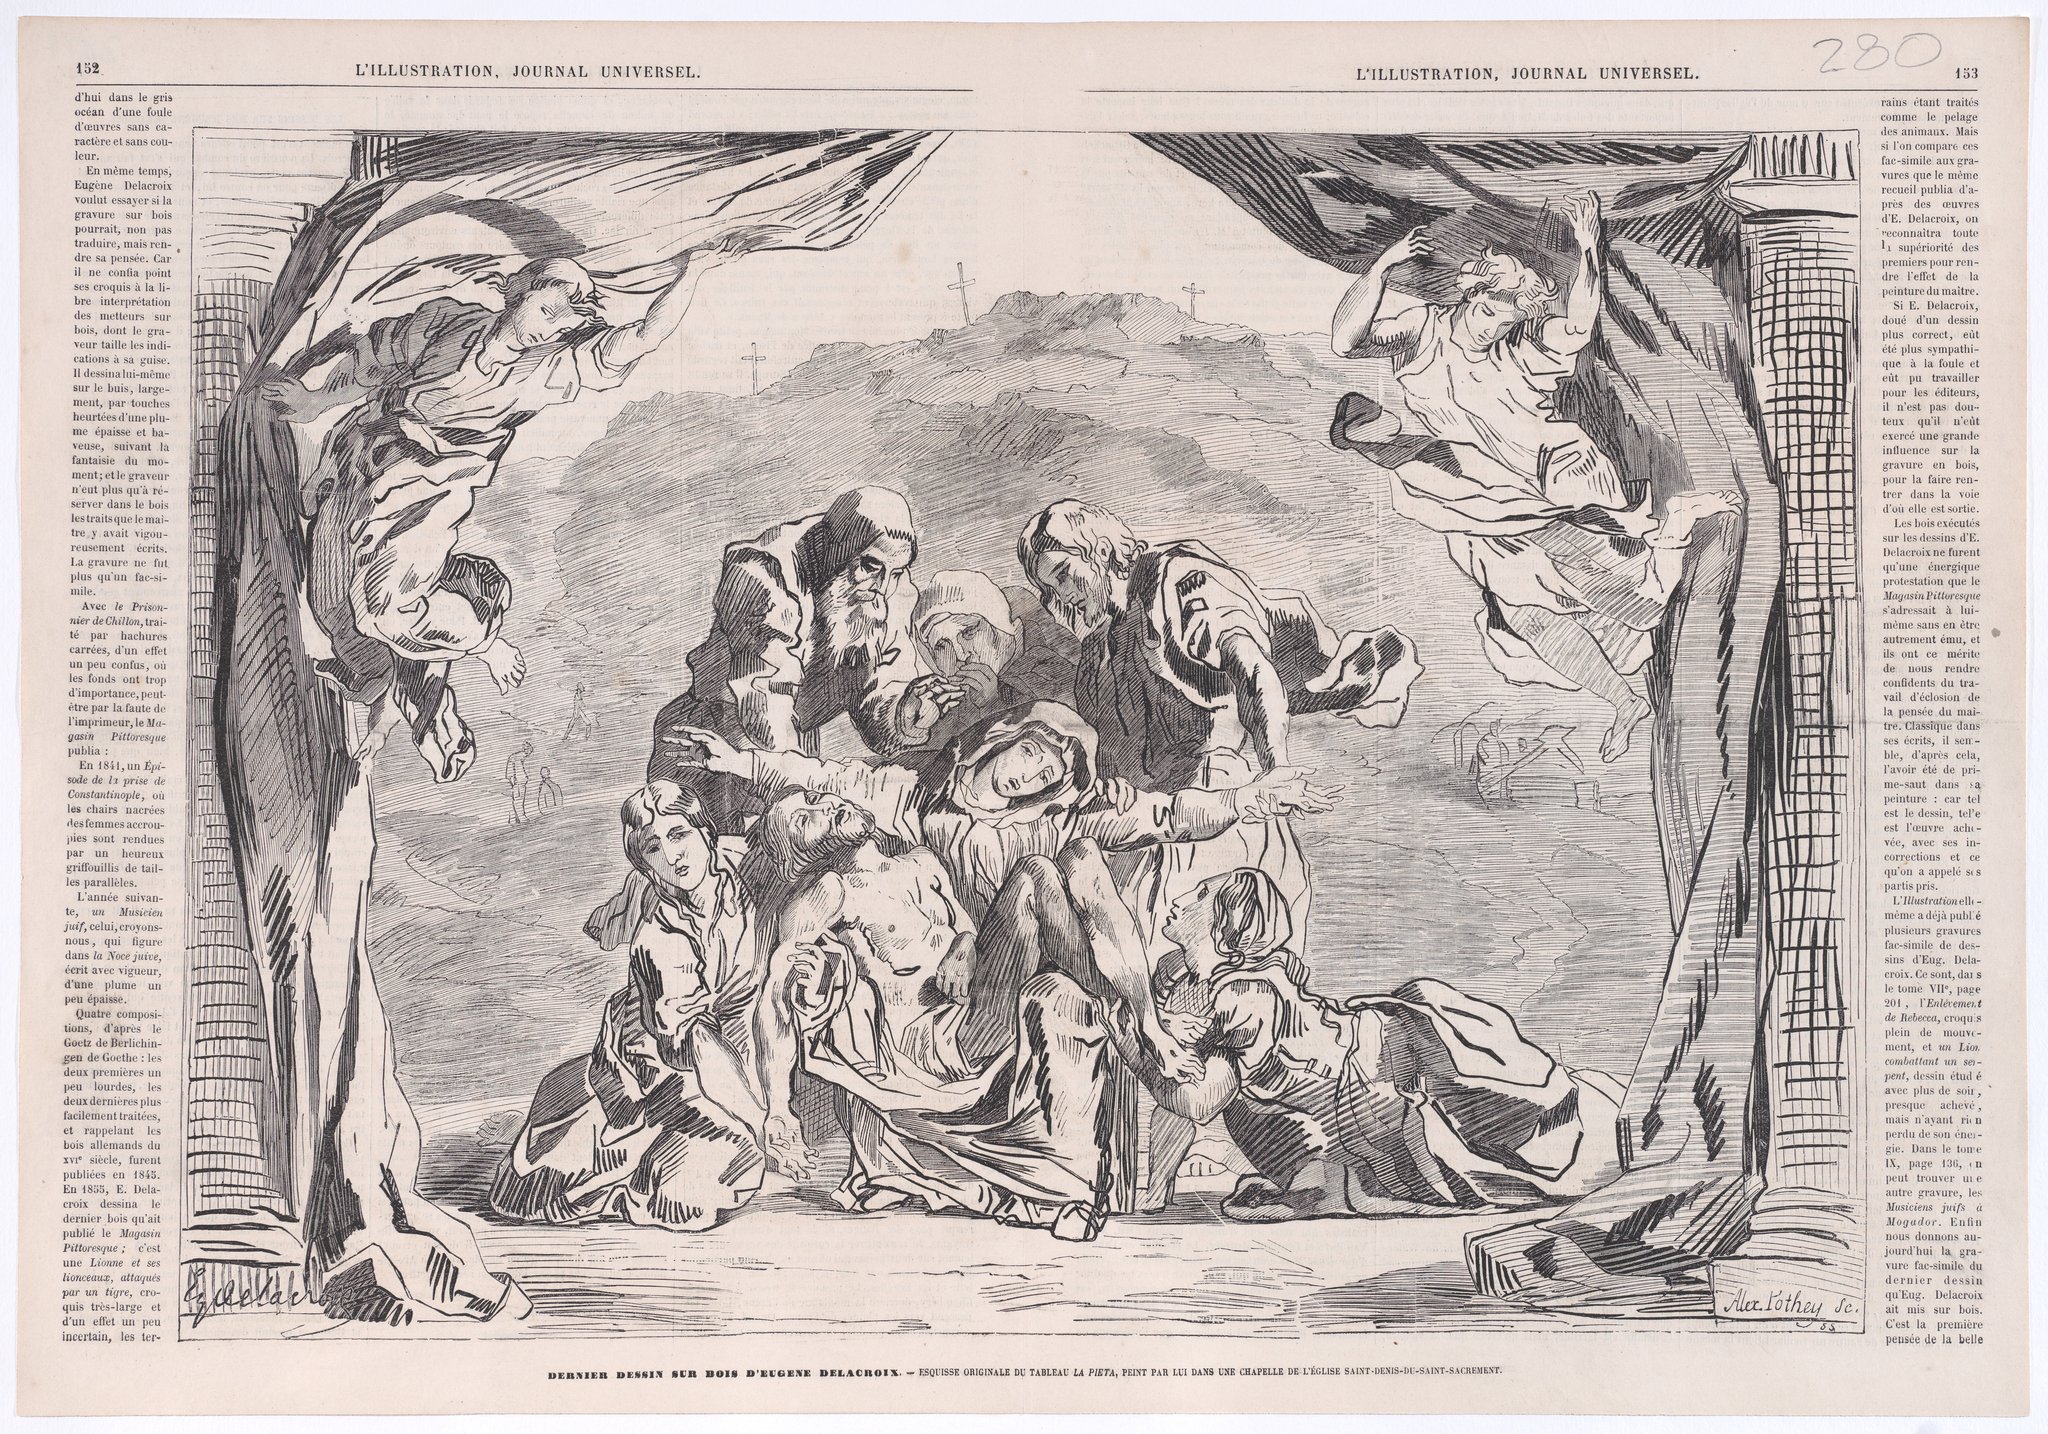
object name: print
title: La Pietà, from "L'Illustration"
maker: eugène delacroix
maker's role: artist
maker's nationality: french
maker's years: 1798-1863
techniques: engraving